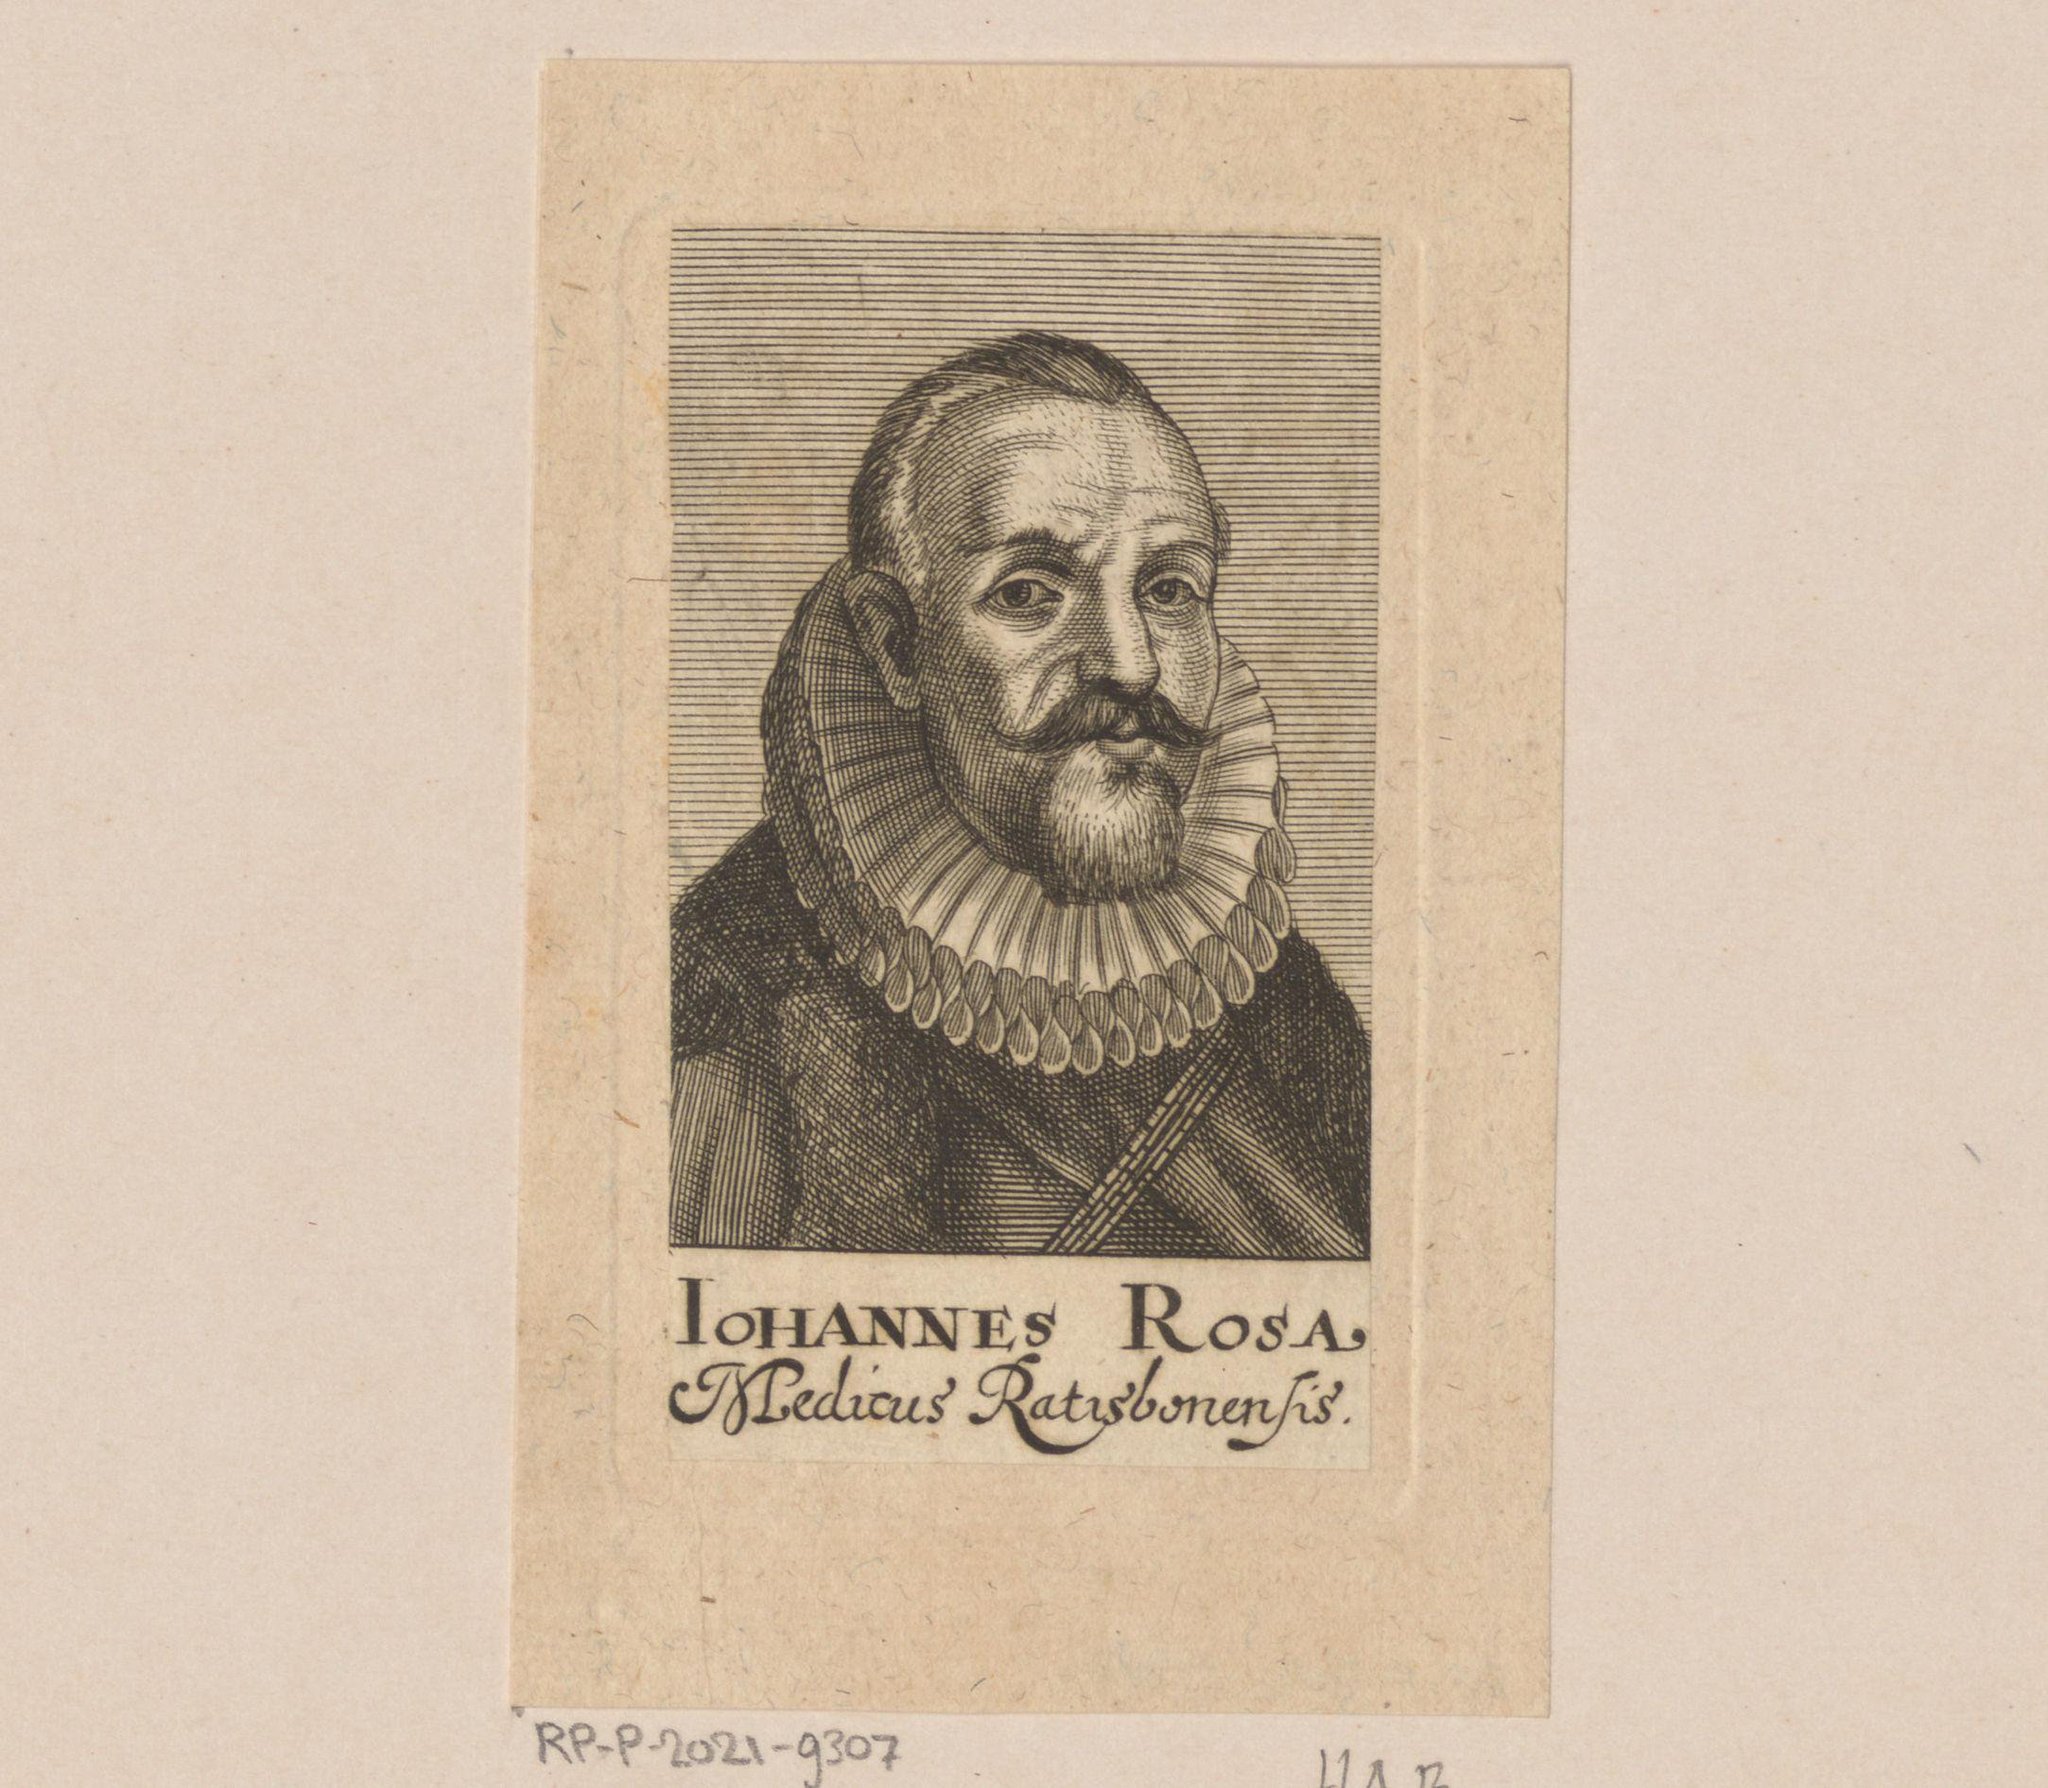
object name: print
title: Portret van Johannes Rosa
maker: Anonymous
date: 1688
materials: paper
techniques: blind stamped, engraving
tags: amberg, historical persons, physician, doctor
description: Prent maakt deel uit van een grotere prent die later is verknipt. Prent waarschijnlijk uit: Freher, Paul. Theatrum virorum eruditione clarorum. Neurenberg: Johann Hoffmann, 1688.